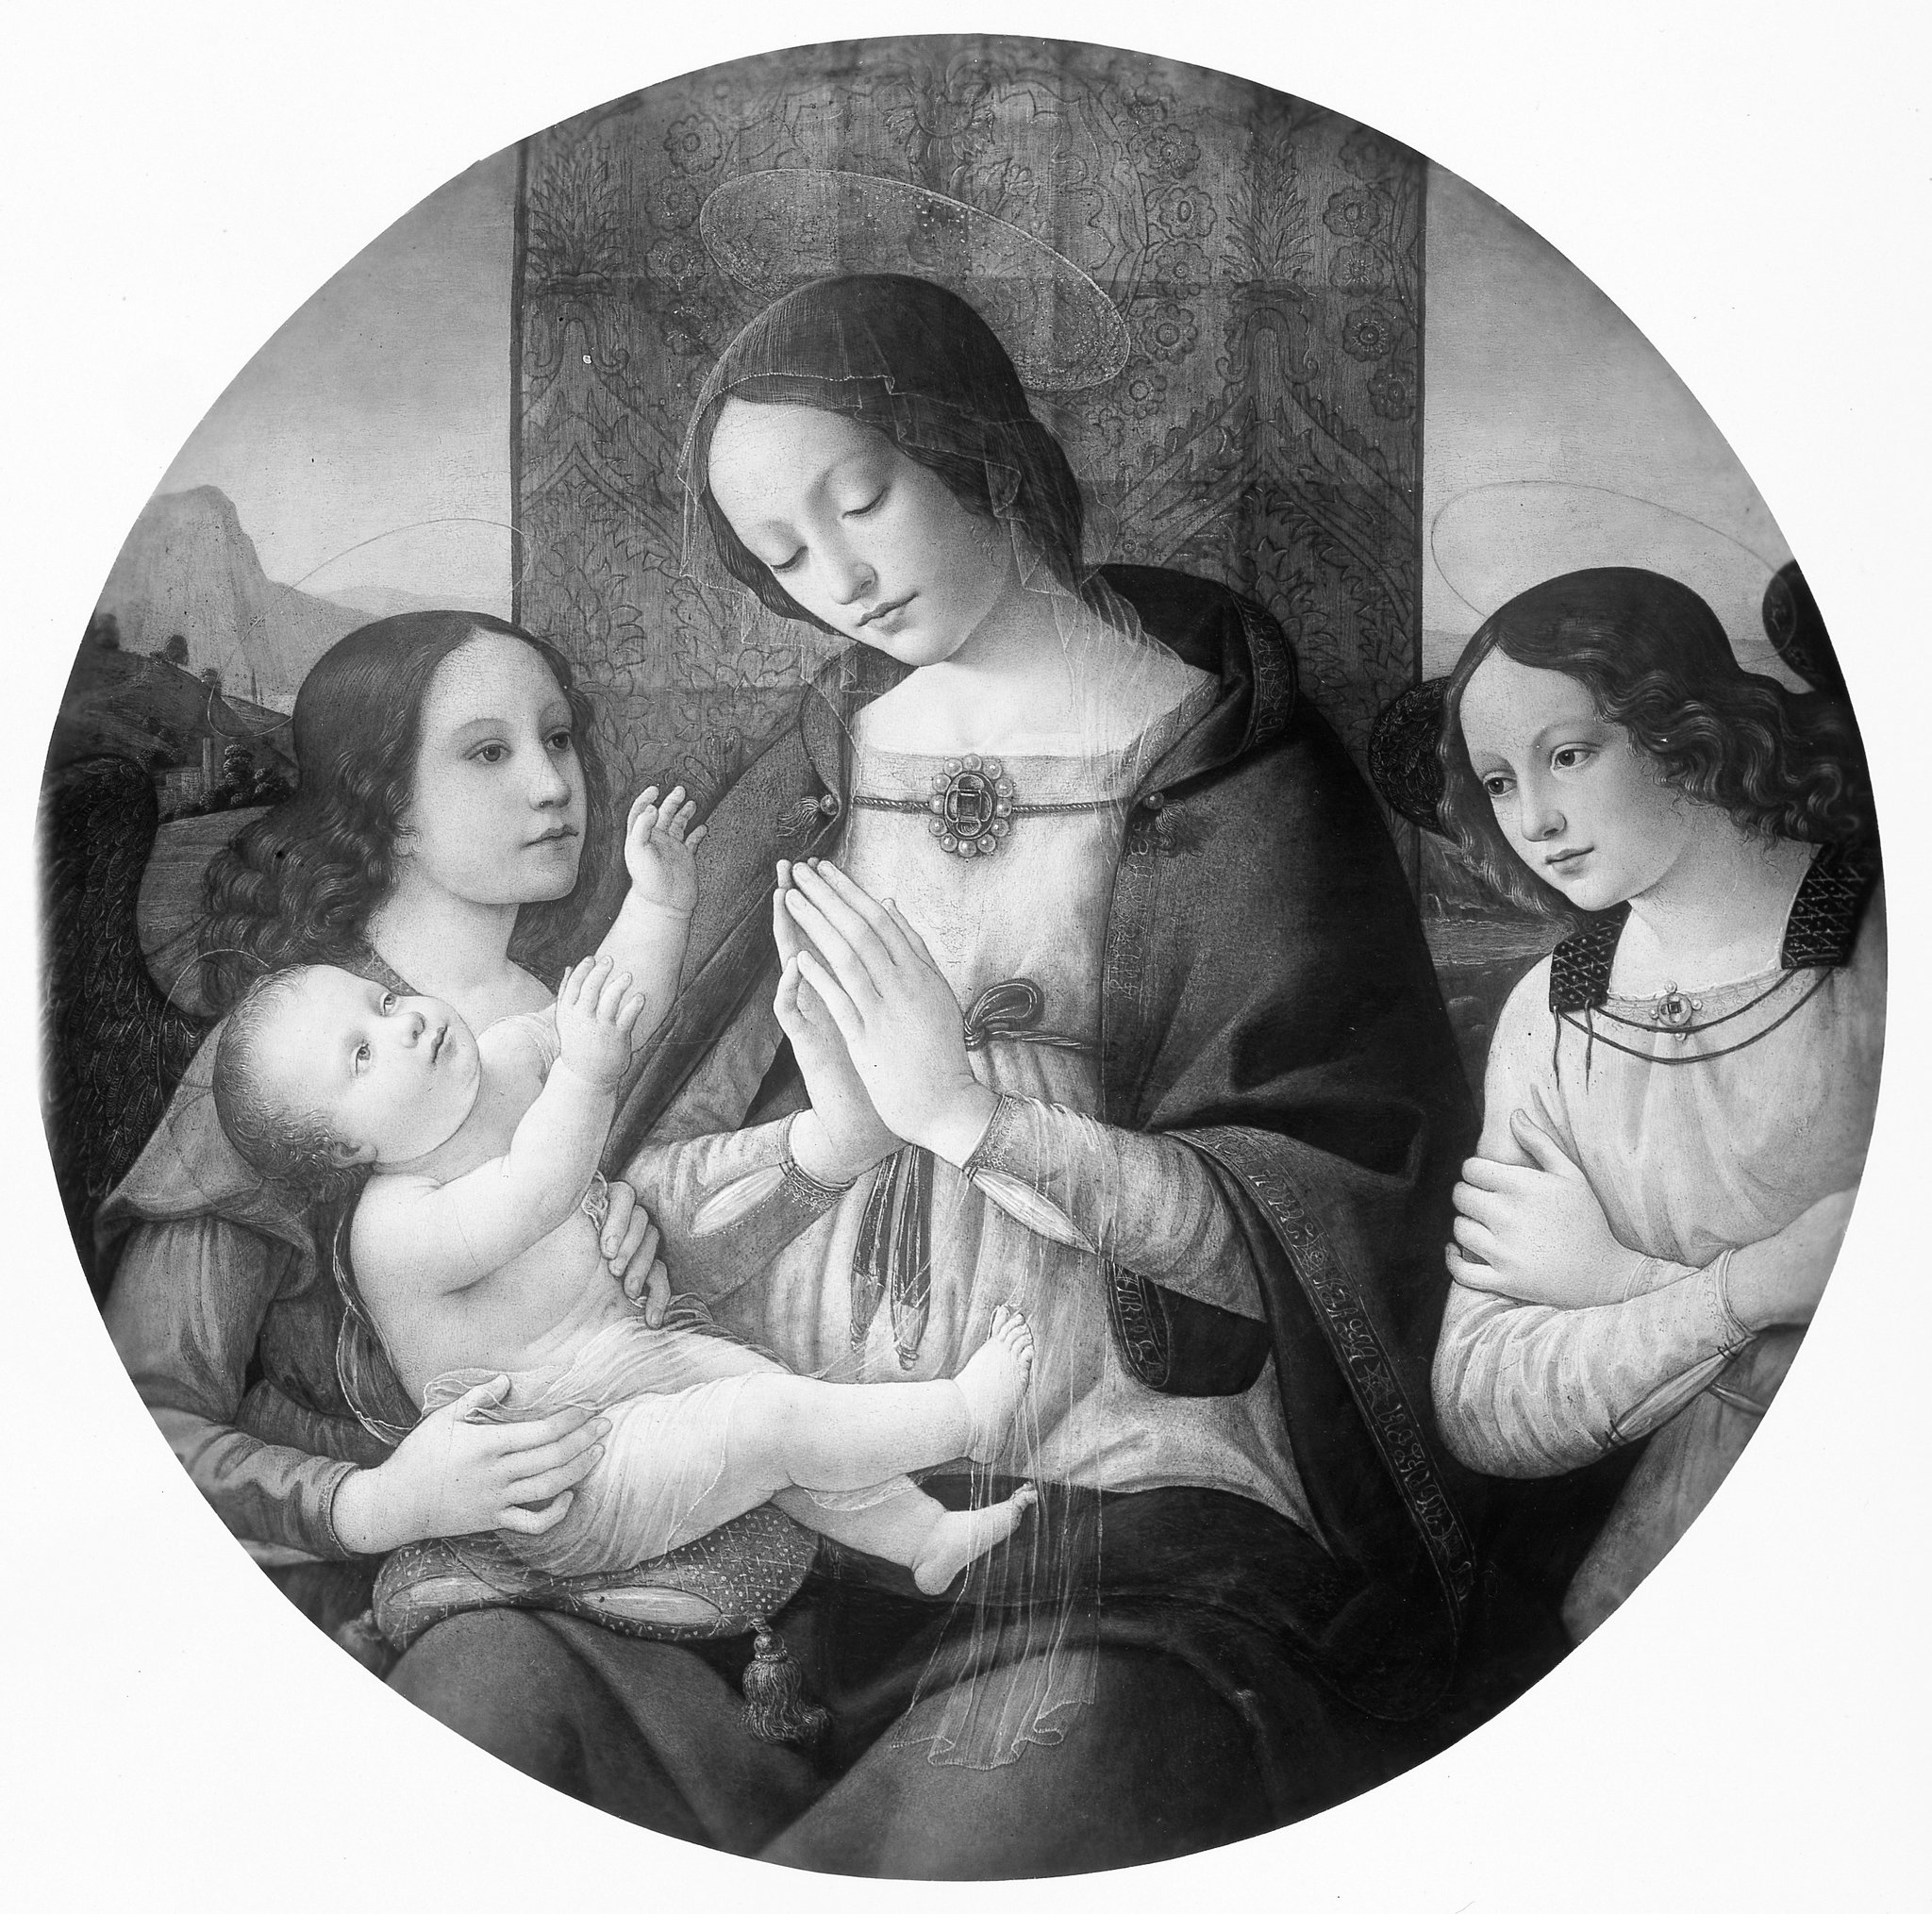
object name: painting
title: Madonna and Child with Angels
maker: domenico ghirlandaio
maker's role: artist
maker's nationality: italian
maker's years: 1448-1494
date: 1469-1494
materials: canvas, paint, wood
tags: angels,madonna and child